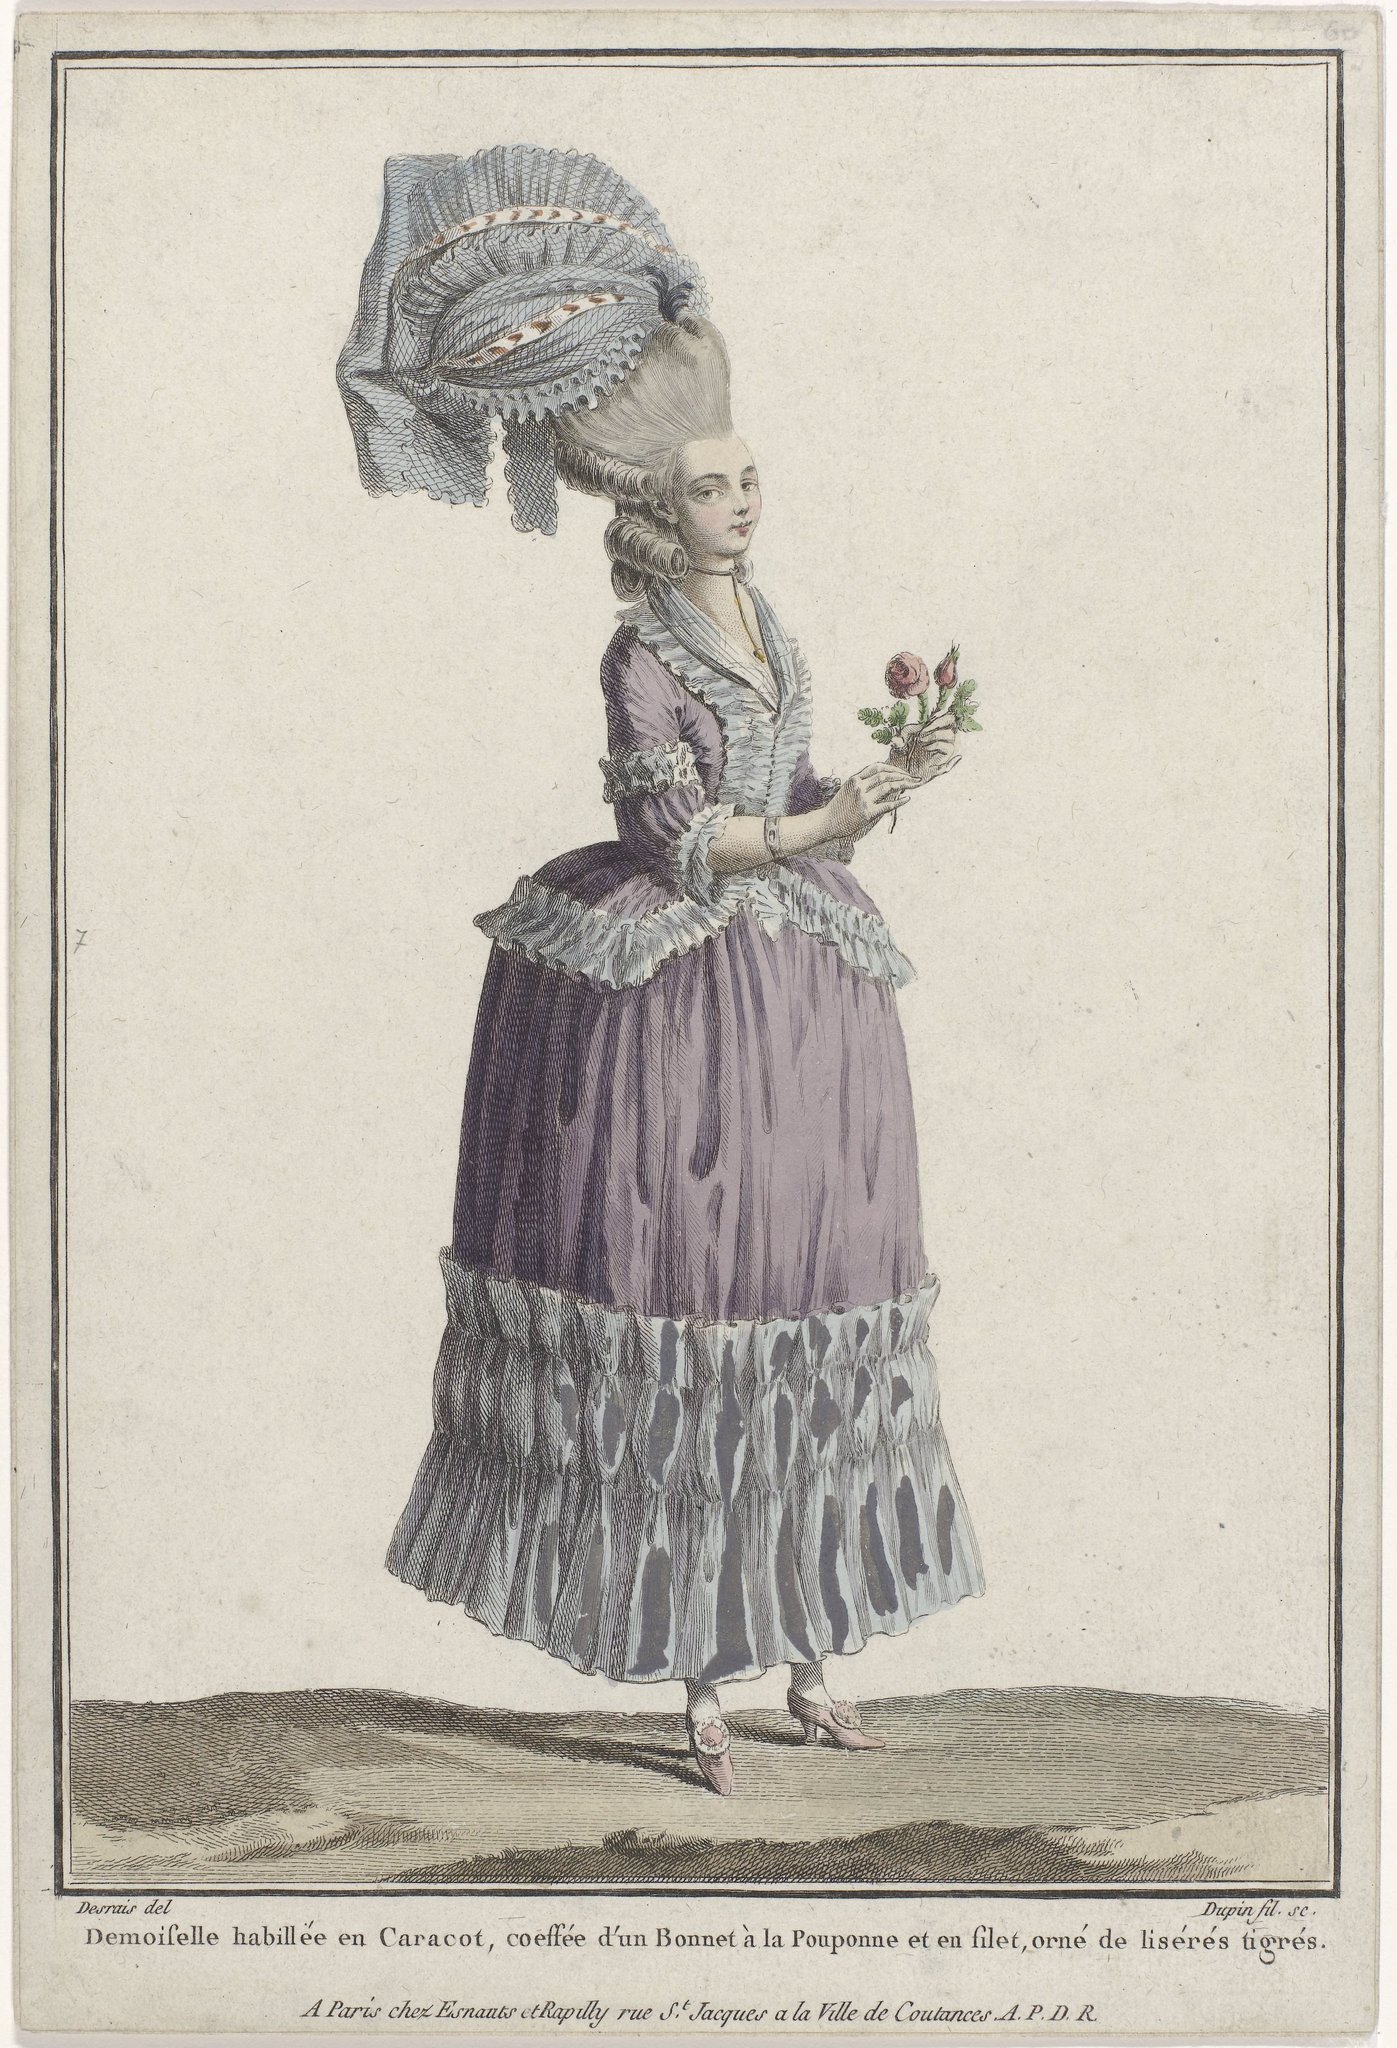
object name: fashion print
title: Gallerie des Modes et Costumes Français, 1778, K 59 : Demoiselle habillée en Caracot (...)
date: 1778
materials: paper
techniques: engraving, hand coloring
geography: paris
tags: clothing for the upper part of the body (caraco) (+ women's clothes), head-gear: cap (+ women's clothes), fashion plates, shoes, sandals (+ women's clothes), skirt (+ women's clothes), piece of clothing covering the breast or décolleté (+ women's clothes), flowers: rose, bracelet, wristlet (+ women's clothes), necklace (+ women's clothes)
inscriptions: caption: ‘Demoiselle habillée en Caracot, coeffée d'un Bonnet à la Pouponne et en filet, orné de lisérés tigrés.’, address: ‘A Paris chez Esnauts et Rapilly rue St. Jacques, a la Ville de Coutances. A.P.D.R.’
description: Ongetrouwde vrouw in een caraco op een rok met falbala. Om de hals een fichu. Op het hoge kapsel een 'Bonnet à la Pouponne', ofwel een muts van filet versierd met gestippeld boordsel. Accessoires: geknoopt koord om de hals, armband, schoenen met hakken en rozetten. Rozentak in de hand. Prent uit serie K. 10e Cahier des Costumes Français, 4e Suite d'Habillemens à la mode, Gallerie des Modes et Costumes Français.